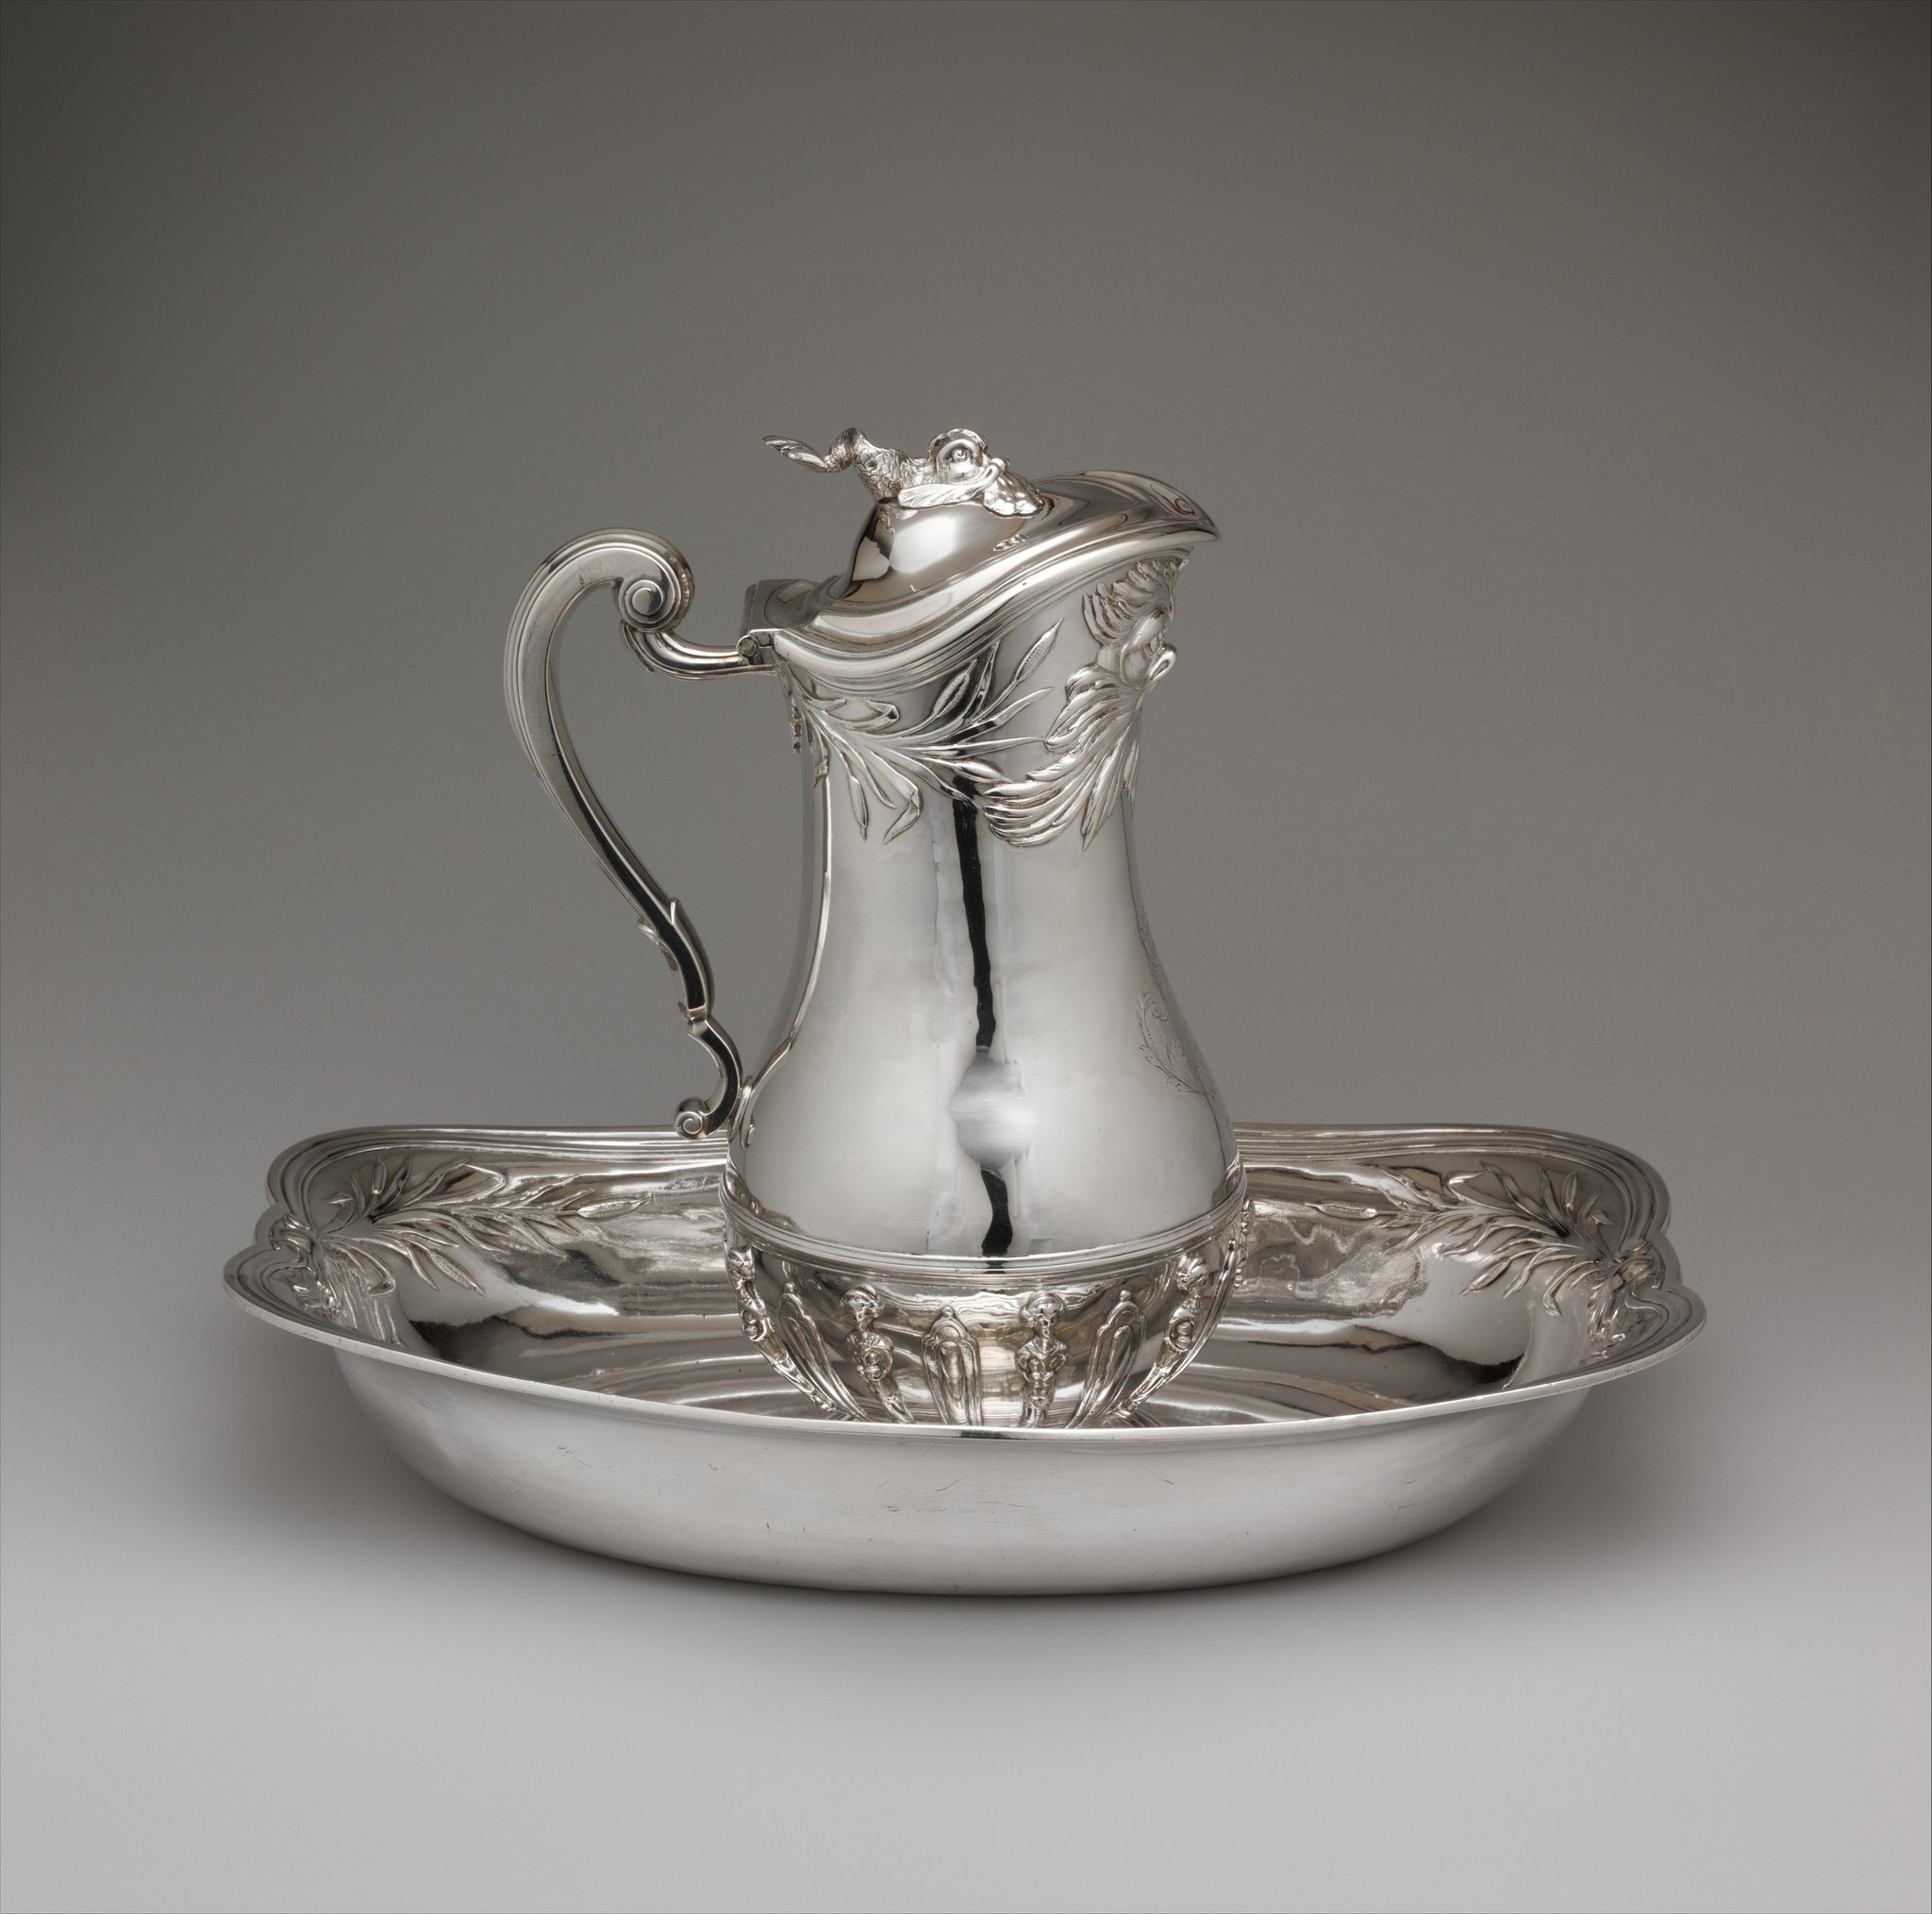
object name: basin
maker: marc bazille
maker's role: maker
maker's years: 1706-1777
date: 1745-1746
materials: silver